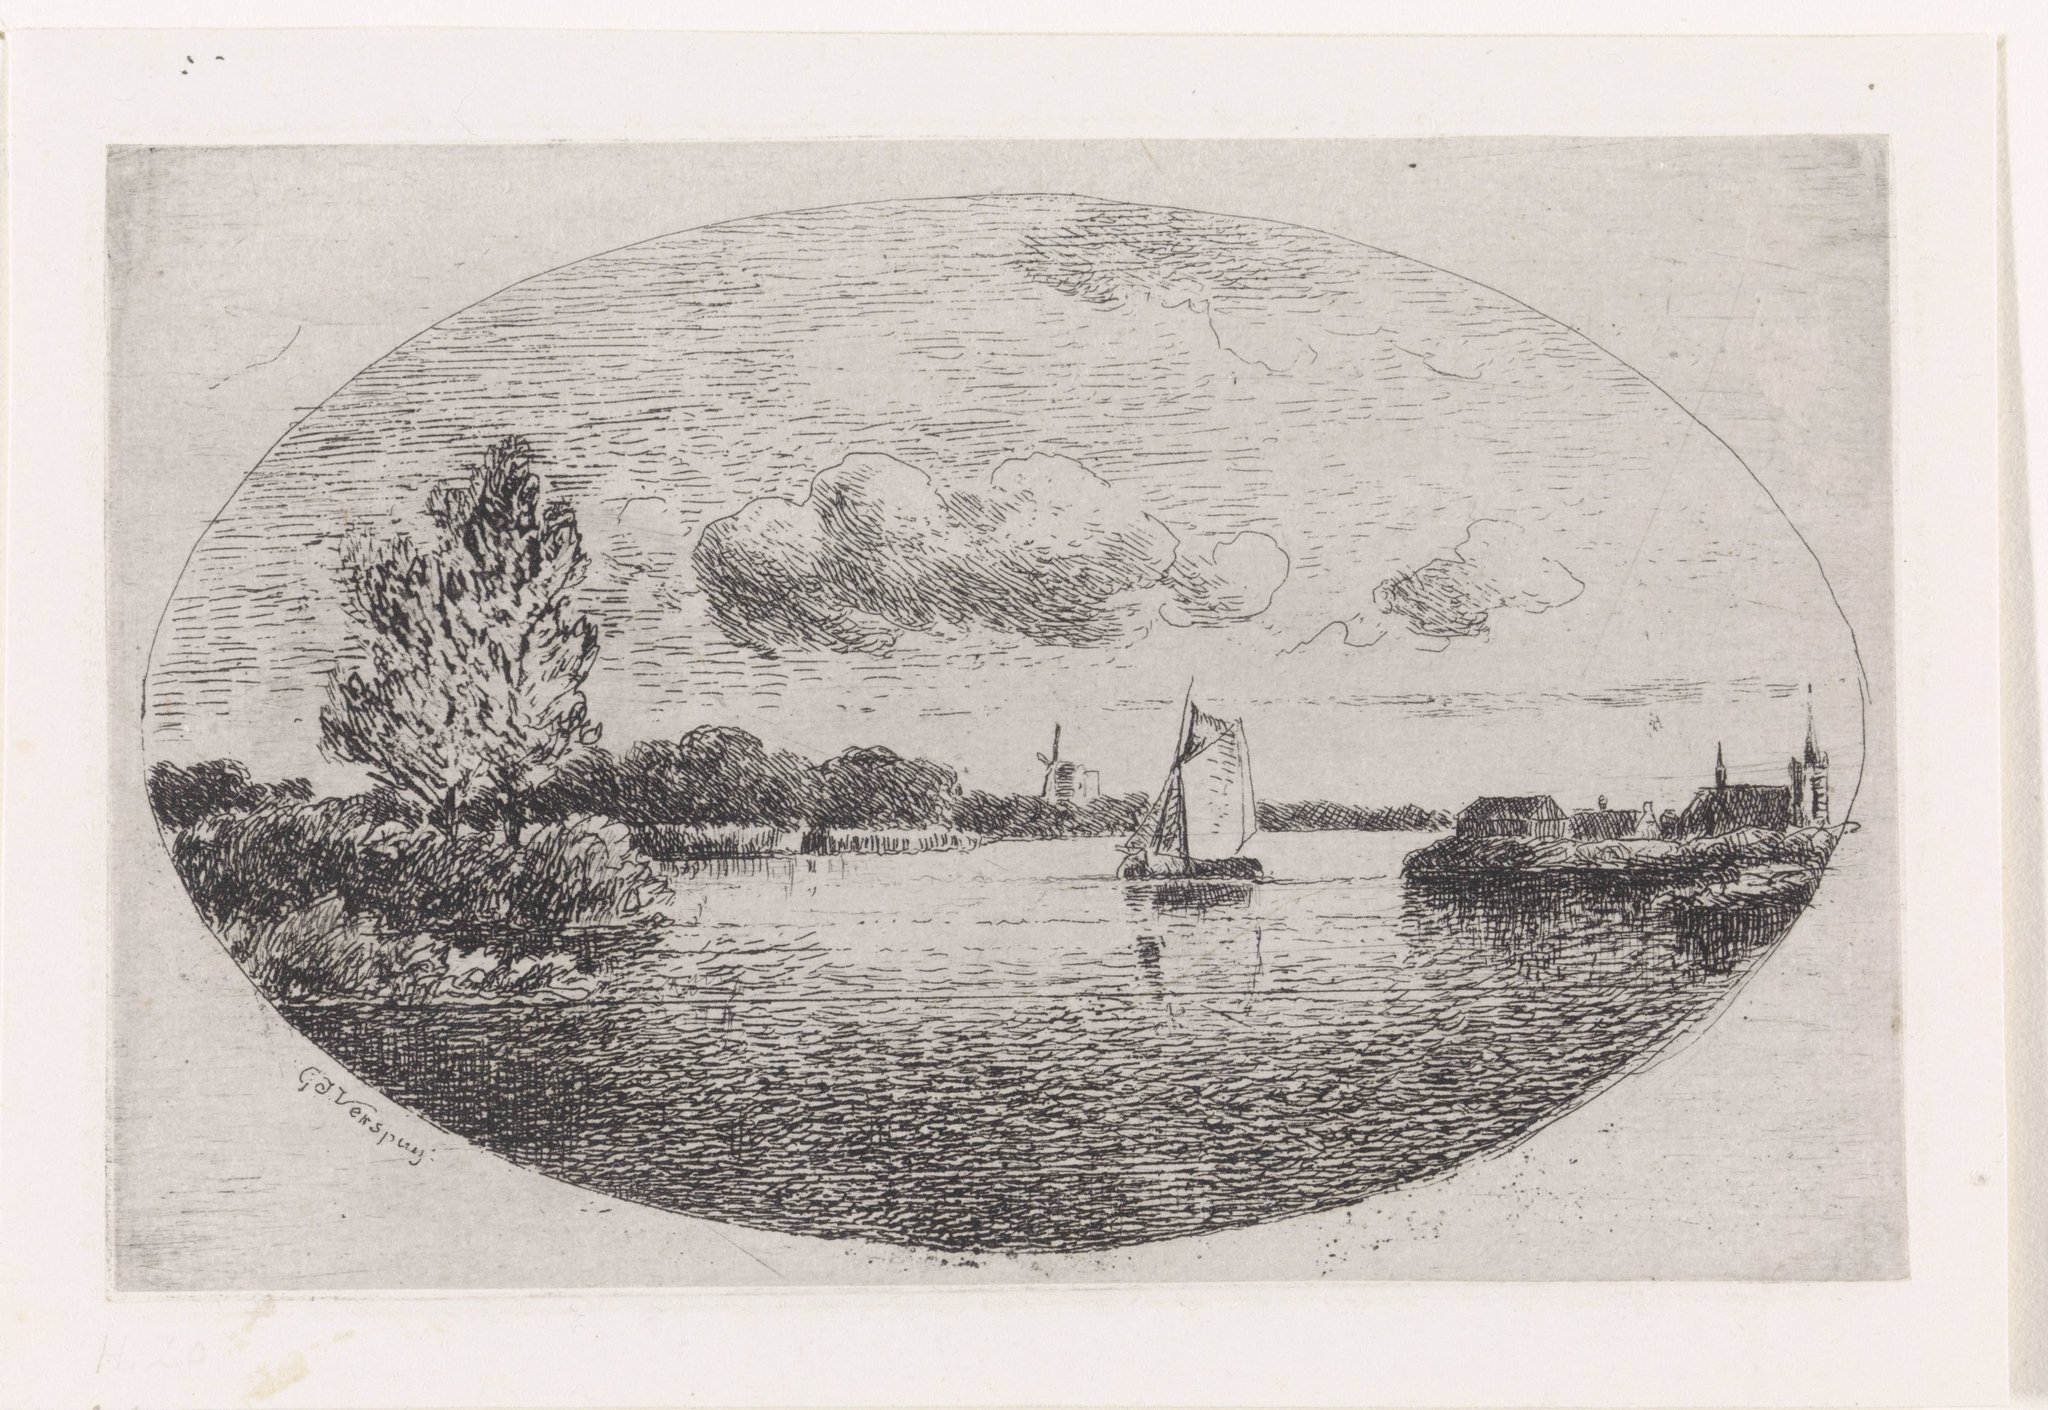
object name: print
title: Riviergezicht met een zeilschip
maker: gijsbertus johannes verspuy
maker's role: print maker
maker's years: 1823-1862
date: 1833-1862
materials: paper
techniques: etching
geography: netherlands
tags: sailing-ship, sailing-boat, river, windmill in landscape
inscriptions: collector's mark: Lugt 2228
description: Een zeilschip op een rivier met op de rechteroever een dorp. In de verte een molen.